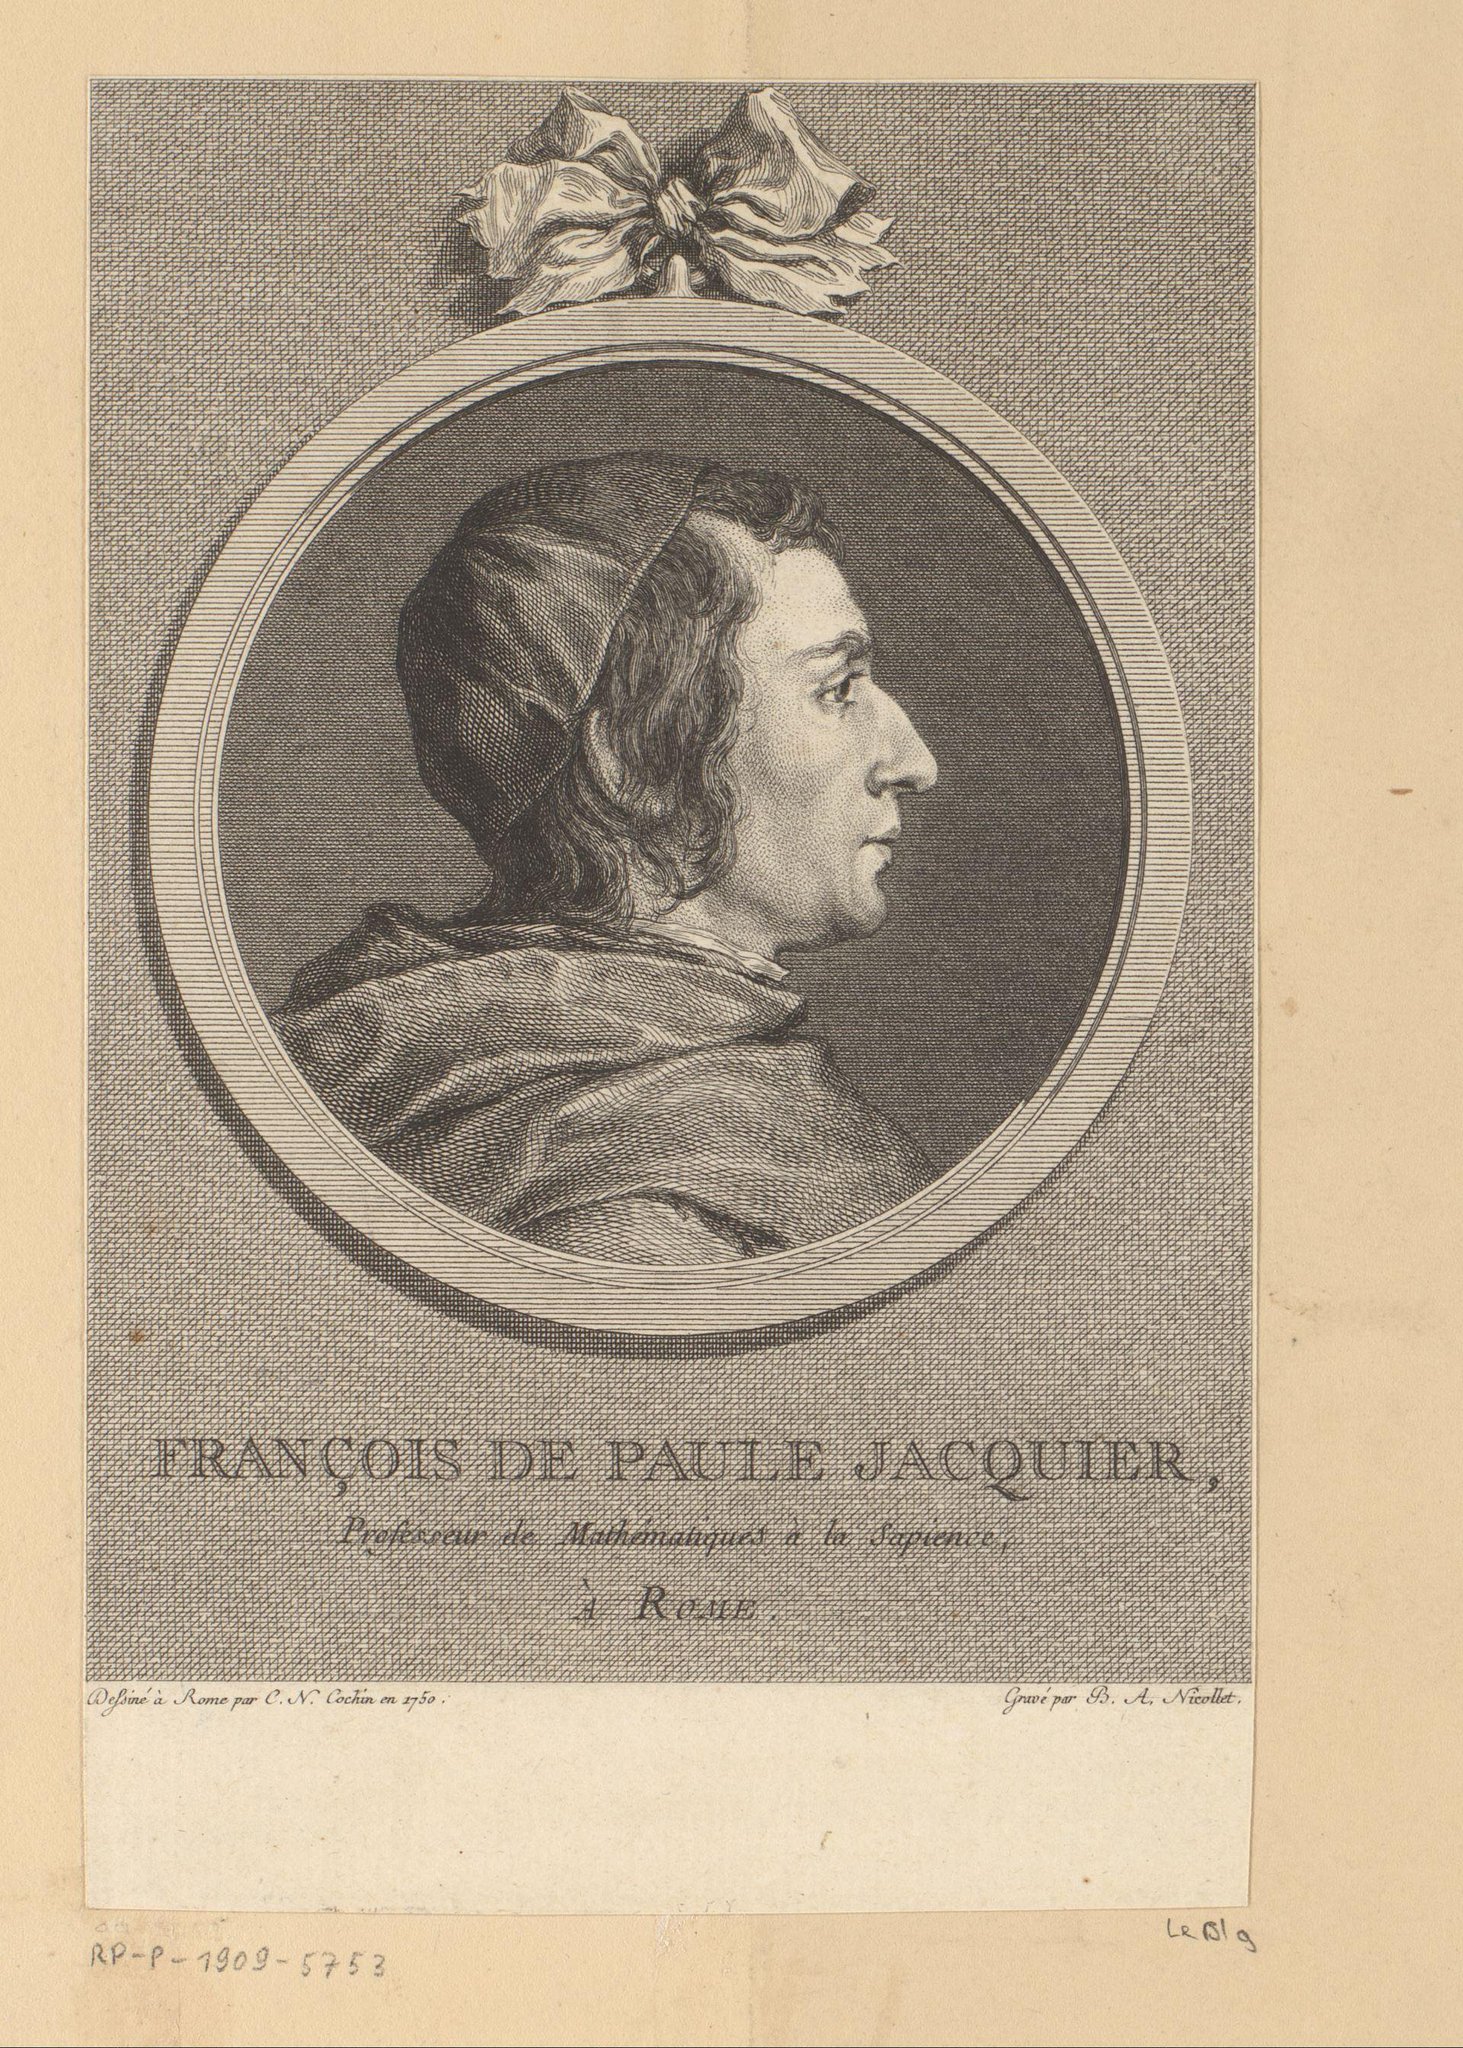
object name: print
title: Portret van François Jacquier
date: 1753-1806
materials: paper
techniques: engraving, etching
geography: rome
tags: rome, historical persons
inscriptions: collector's mark: Lugt 2228